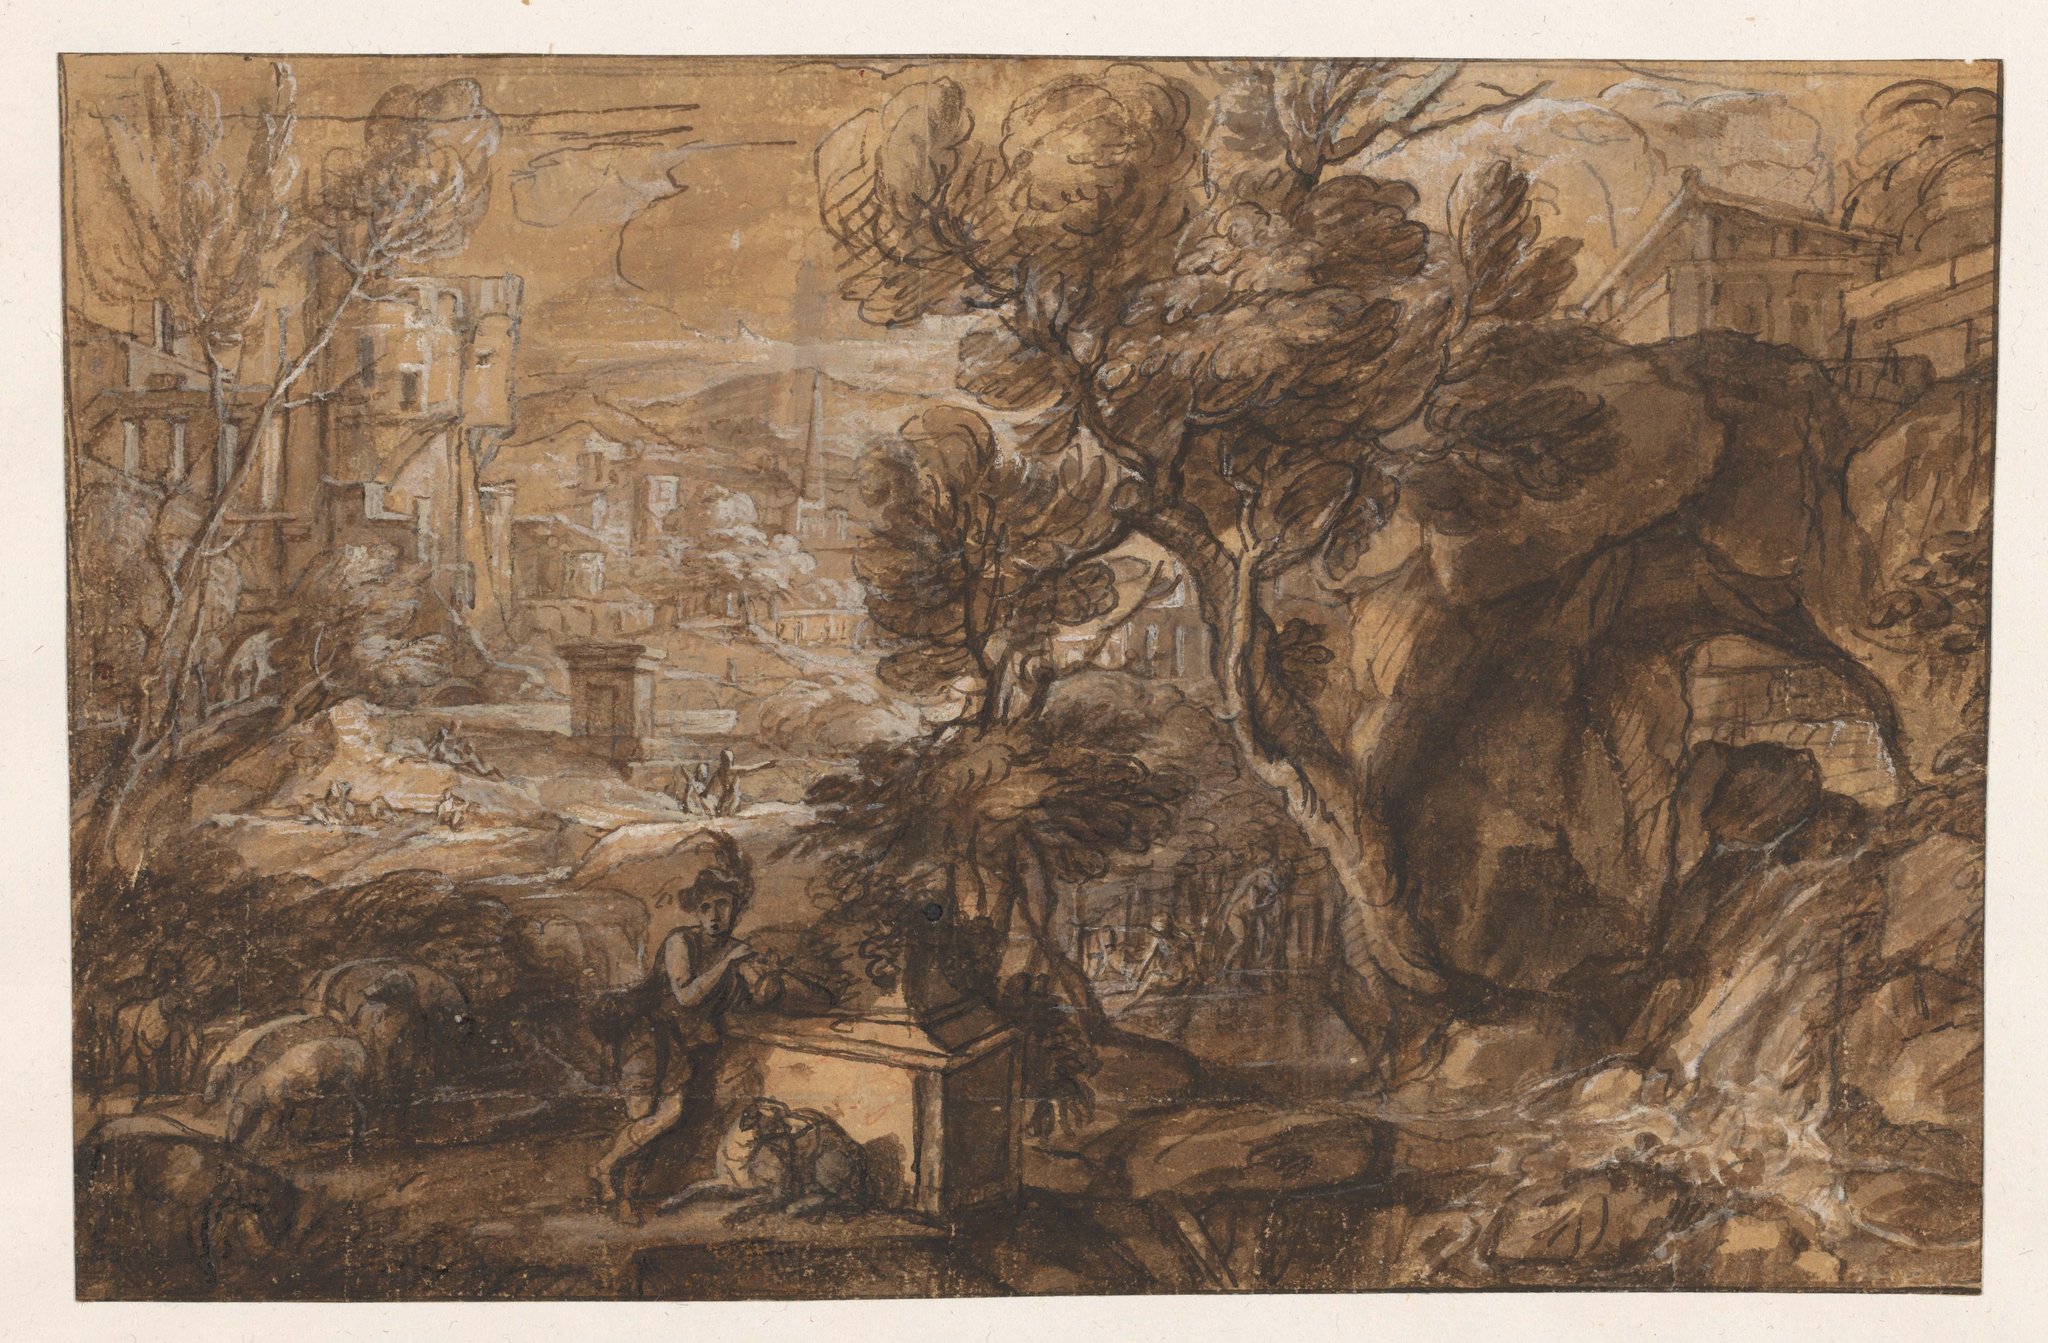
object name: drawing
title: Landschap met herder bij antieke sarcofaag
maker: sébastien bourdon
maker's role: draughtsman, painter, print maker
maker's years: 1616-1671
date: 1626-1671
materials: ink, paper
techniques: brush, pen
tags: herding, herdsman, herdswoman, shepherd, shepherdess, cowherd, etc., landscape with ruins, pastorals, arcadian scenes